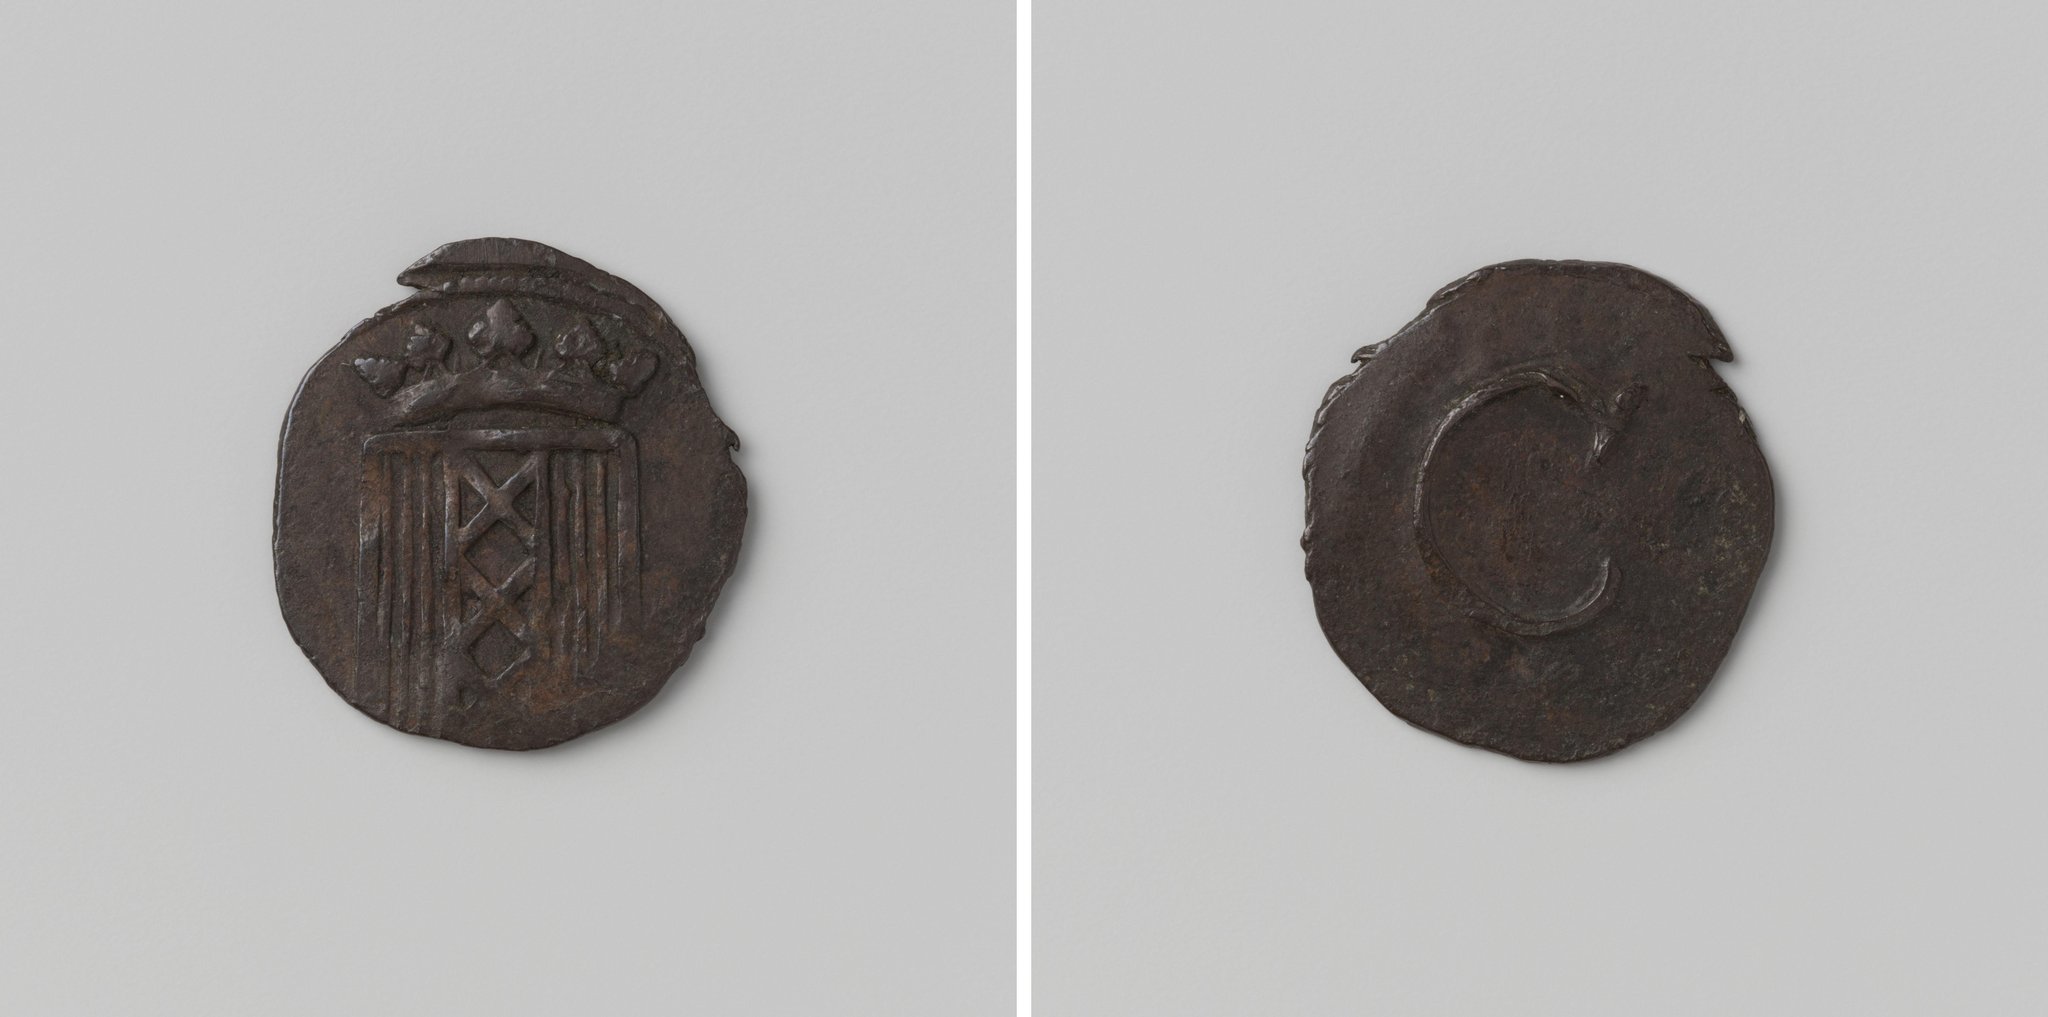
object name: armenloodje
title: Stad Amsterdam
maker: Anonymous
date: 1600-1800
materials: copper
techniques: striking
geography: amsterdam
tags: amsterdam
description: Koperen penning. Voorzijde: gekroond wapenschild. Keerzijde: letter C